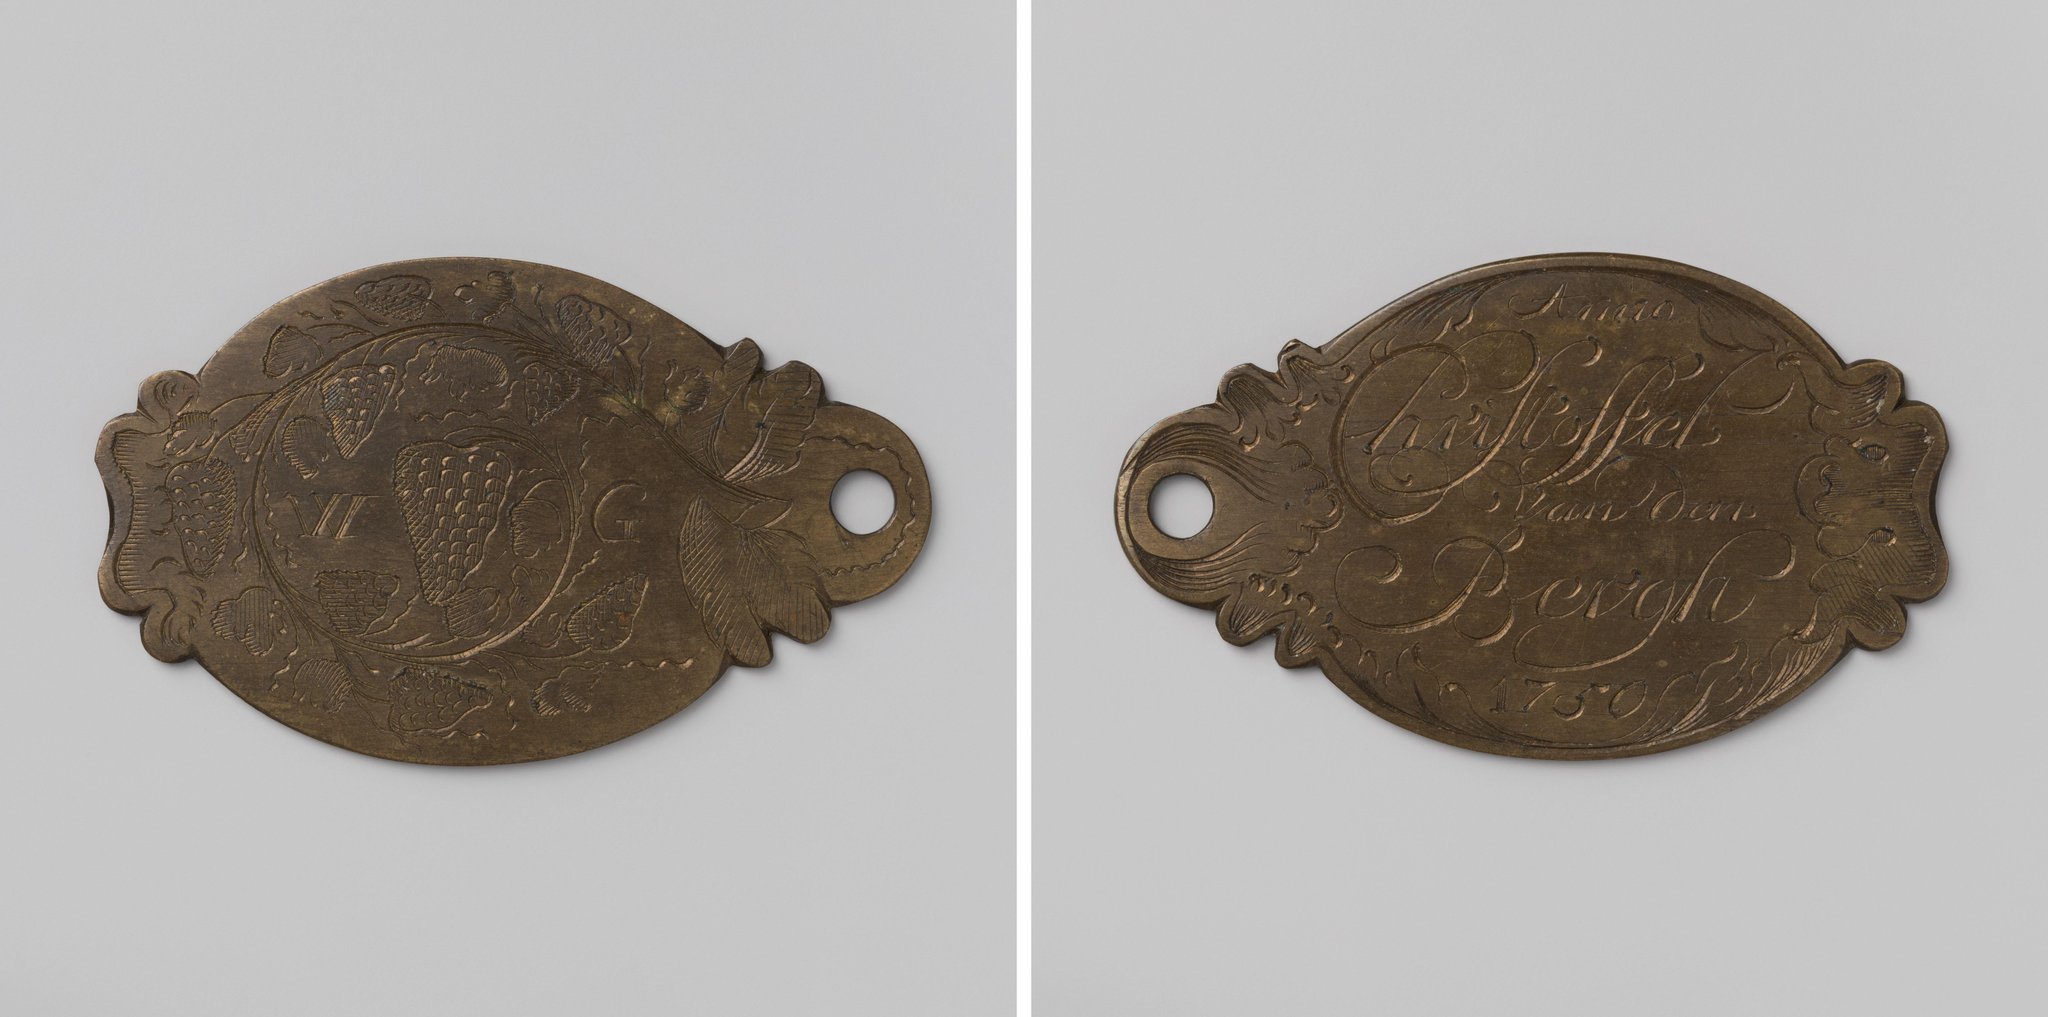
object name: medal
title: Wijnkopersgilde van Nijmegen, gildepenning van Christoffel van den Bergh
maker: Anonymous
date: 1750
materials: brass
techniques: engraving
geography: nijmegen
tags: nijmegen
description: Messing bladvormige penning met gat aan rechterzijde en geschulpte rand. Voorzijde: druivetros geflankeerd door letters W en G omgeven door wijnranken waaraan druivetrossen hangen. Keerzijde: opschrift binnen sierrand.